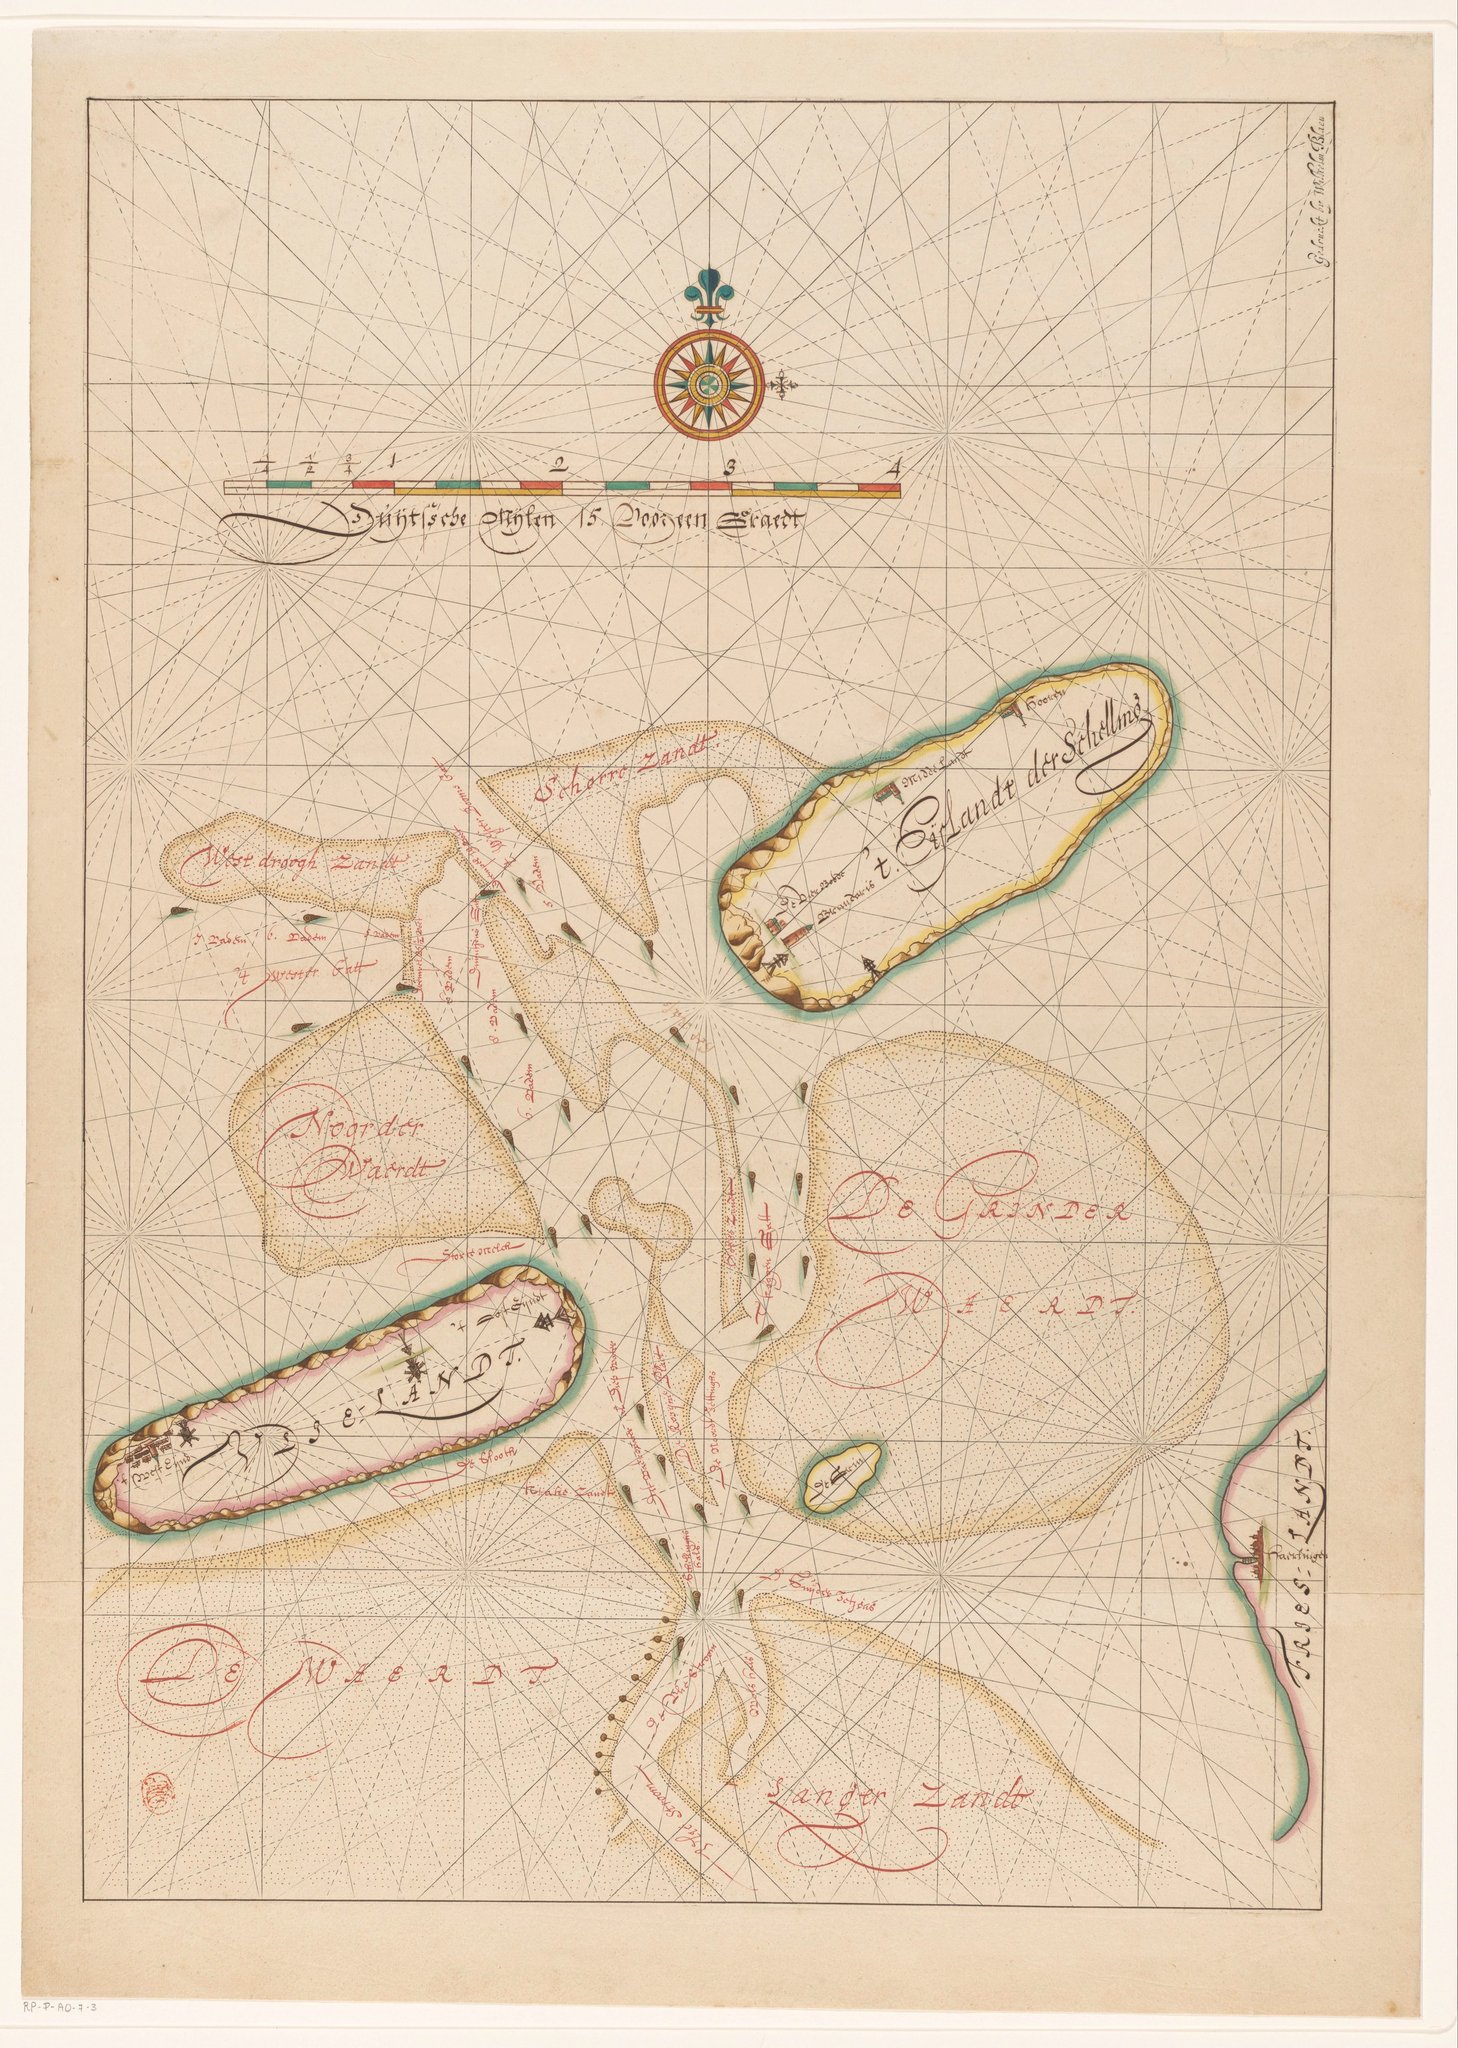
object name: map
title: Kaart van Vlieland, Terschelling, een deel van Friesland en de omliggende zandbanken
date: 1620-1699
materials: ink, paper, watercolor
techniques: brush, engraving, pen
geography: amsterdam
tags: maps of separate countries or regions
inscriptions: collector's mark: Lugt 195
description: Manuscriptkaart op een gedrukt blad met gegraveerde kompaslijnen. Voor een soortgelijke kaart van de Kop van Noord-Holland en Texel, zie RP-P-AO-7-8.